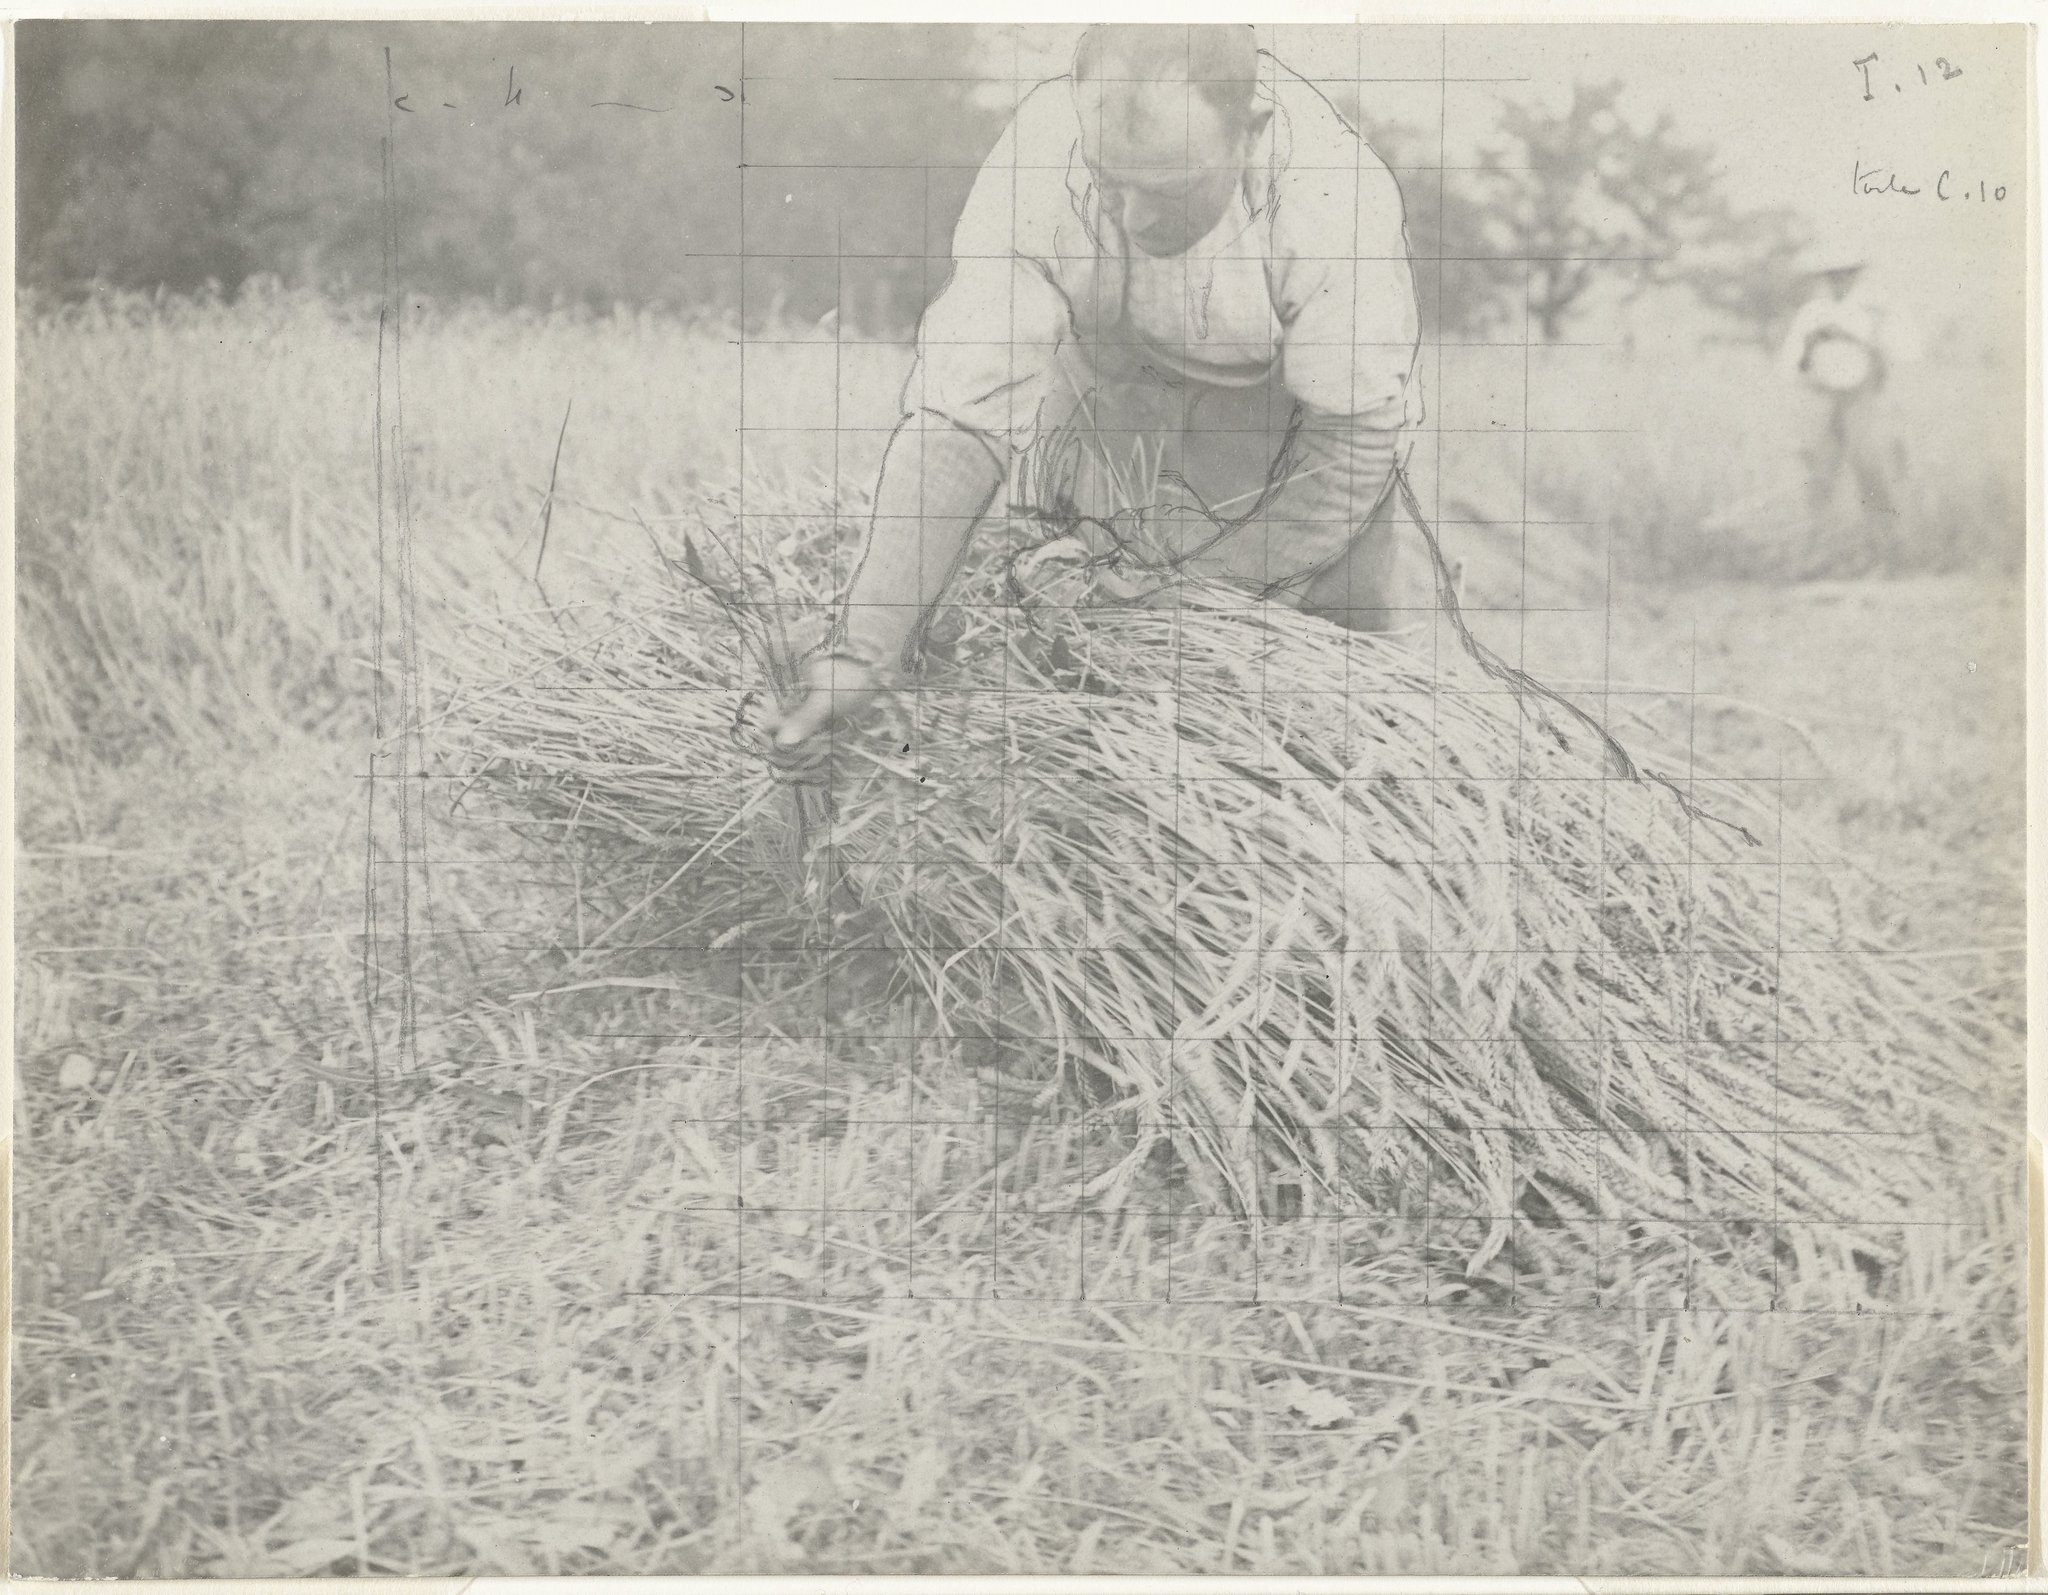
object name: photograph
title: Boer die korenschoof bundelt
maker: henry baudot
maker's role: fotograaf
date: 1900-1920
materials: paper, cardboard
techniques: gelatin silver print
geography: france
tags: weeding, france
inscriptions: inscription: ‘T.12/ [...] C.10’